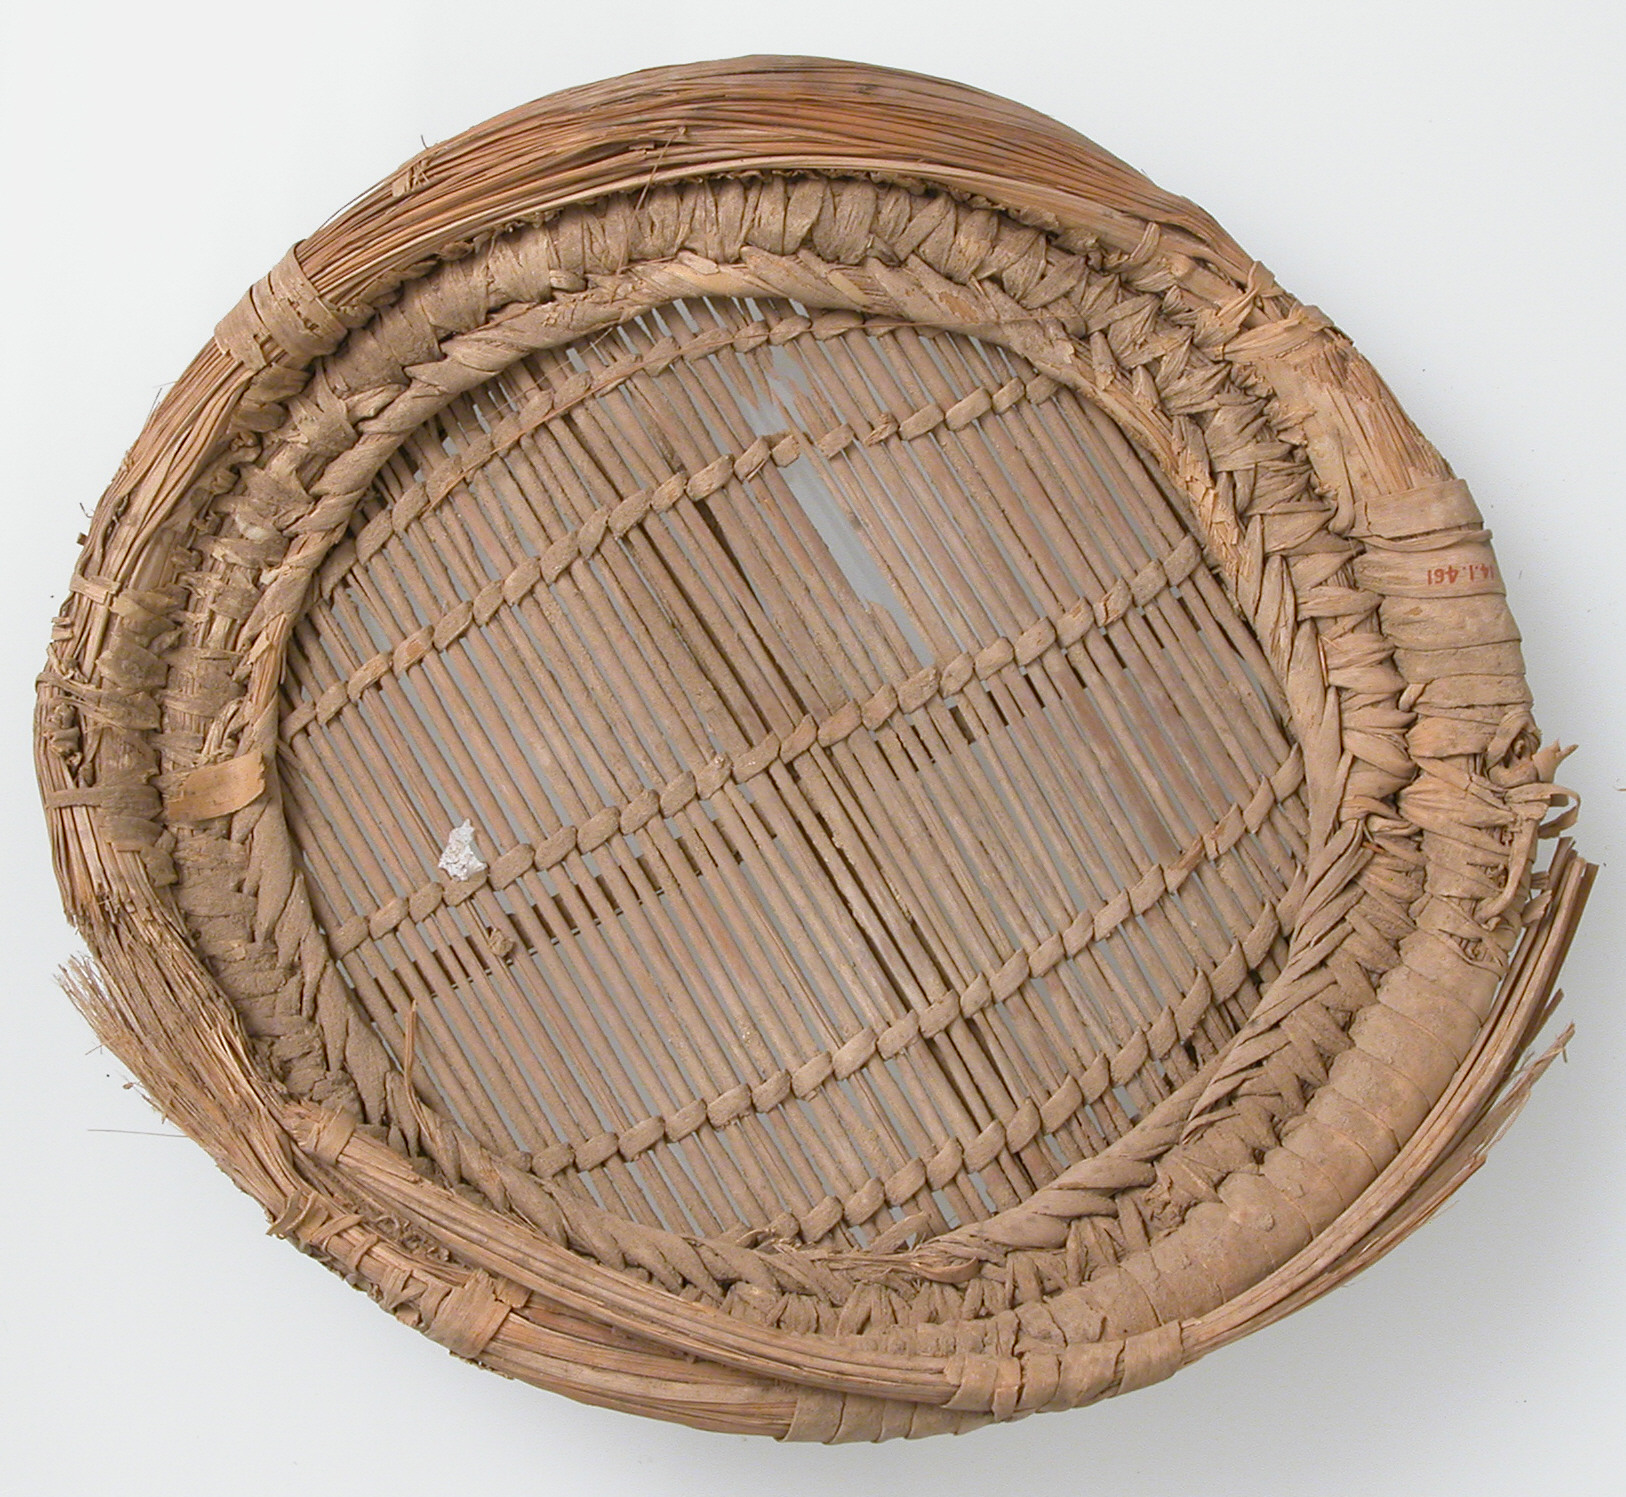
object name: sieve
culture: coptic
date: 580-640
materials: fiber, leaf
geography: egypt